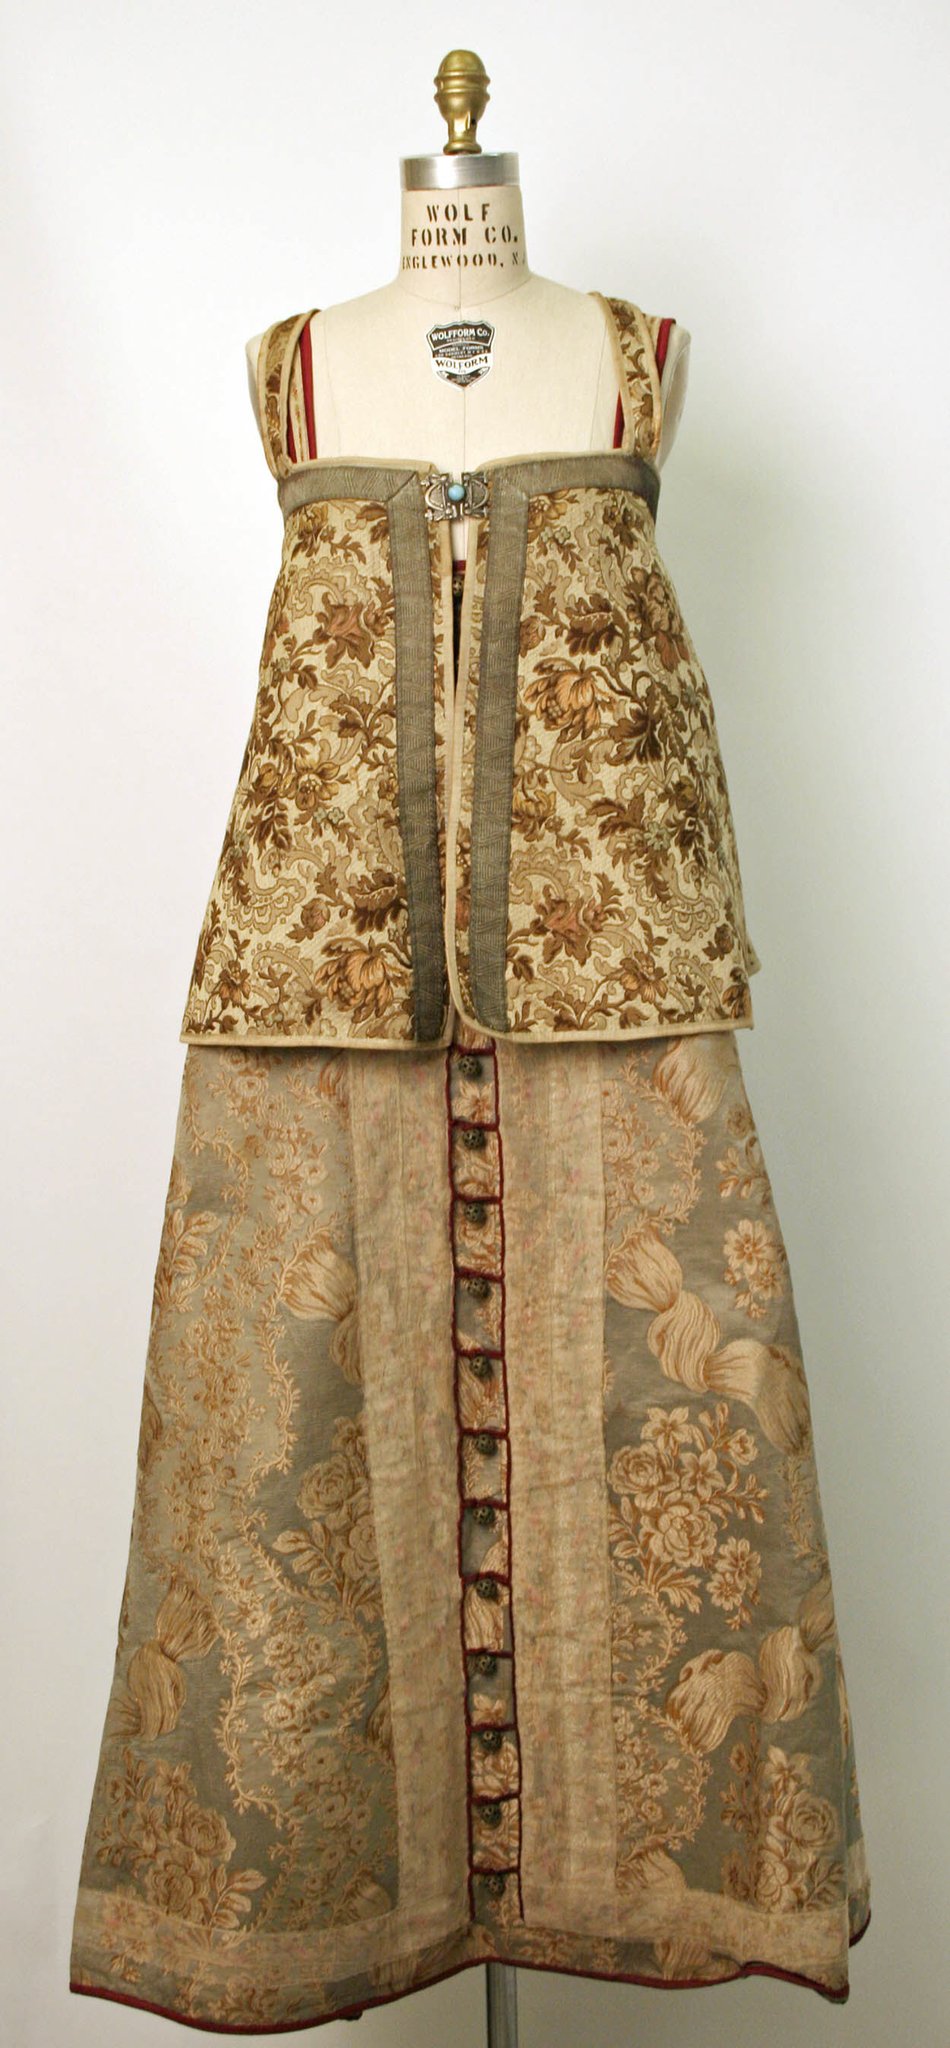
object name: ensemble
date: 1801-1900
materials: cotton, linen, silk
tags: flowers